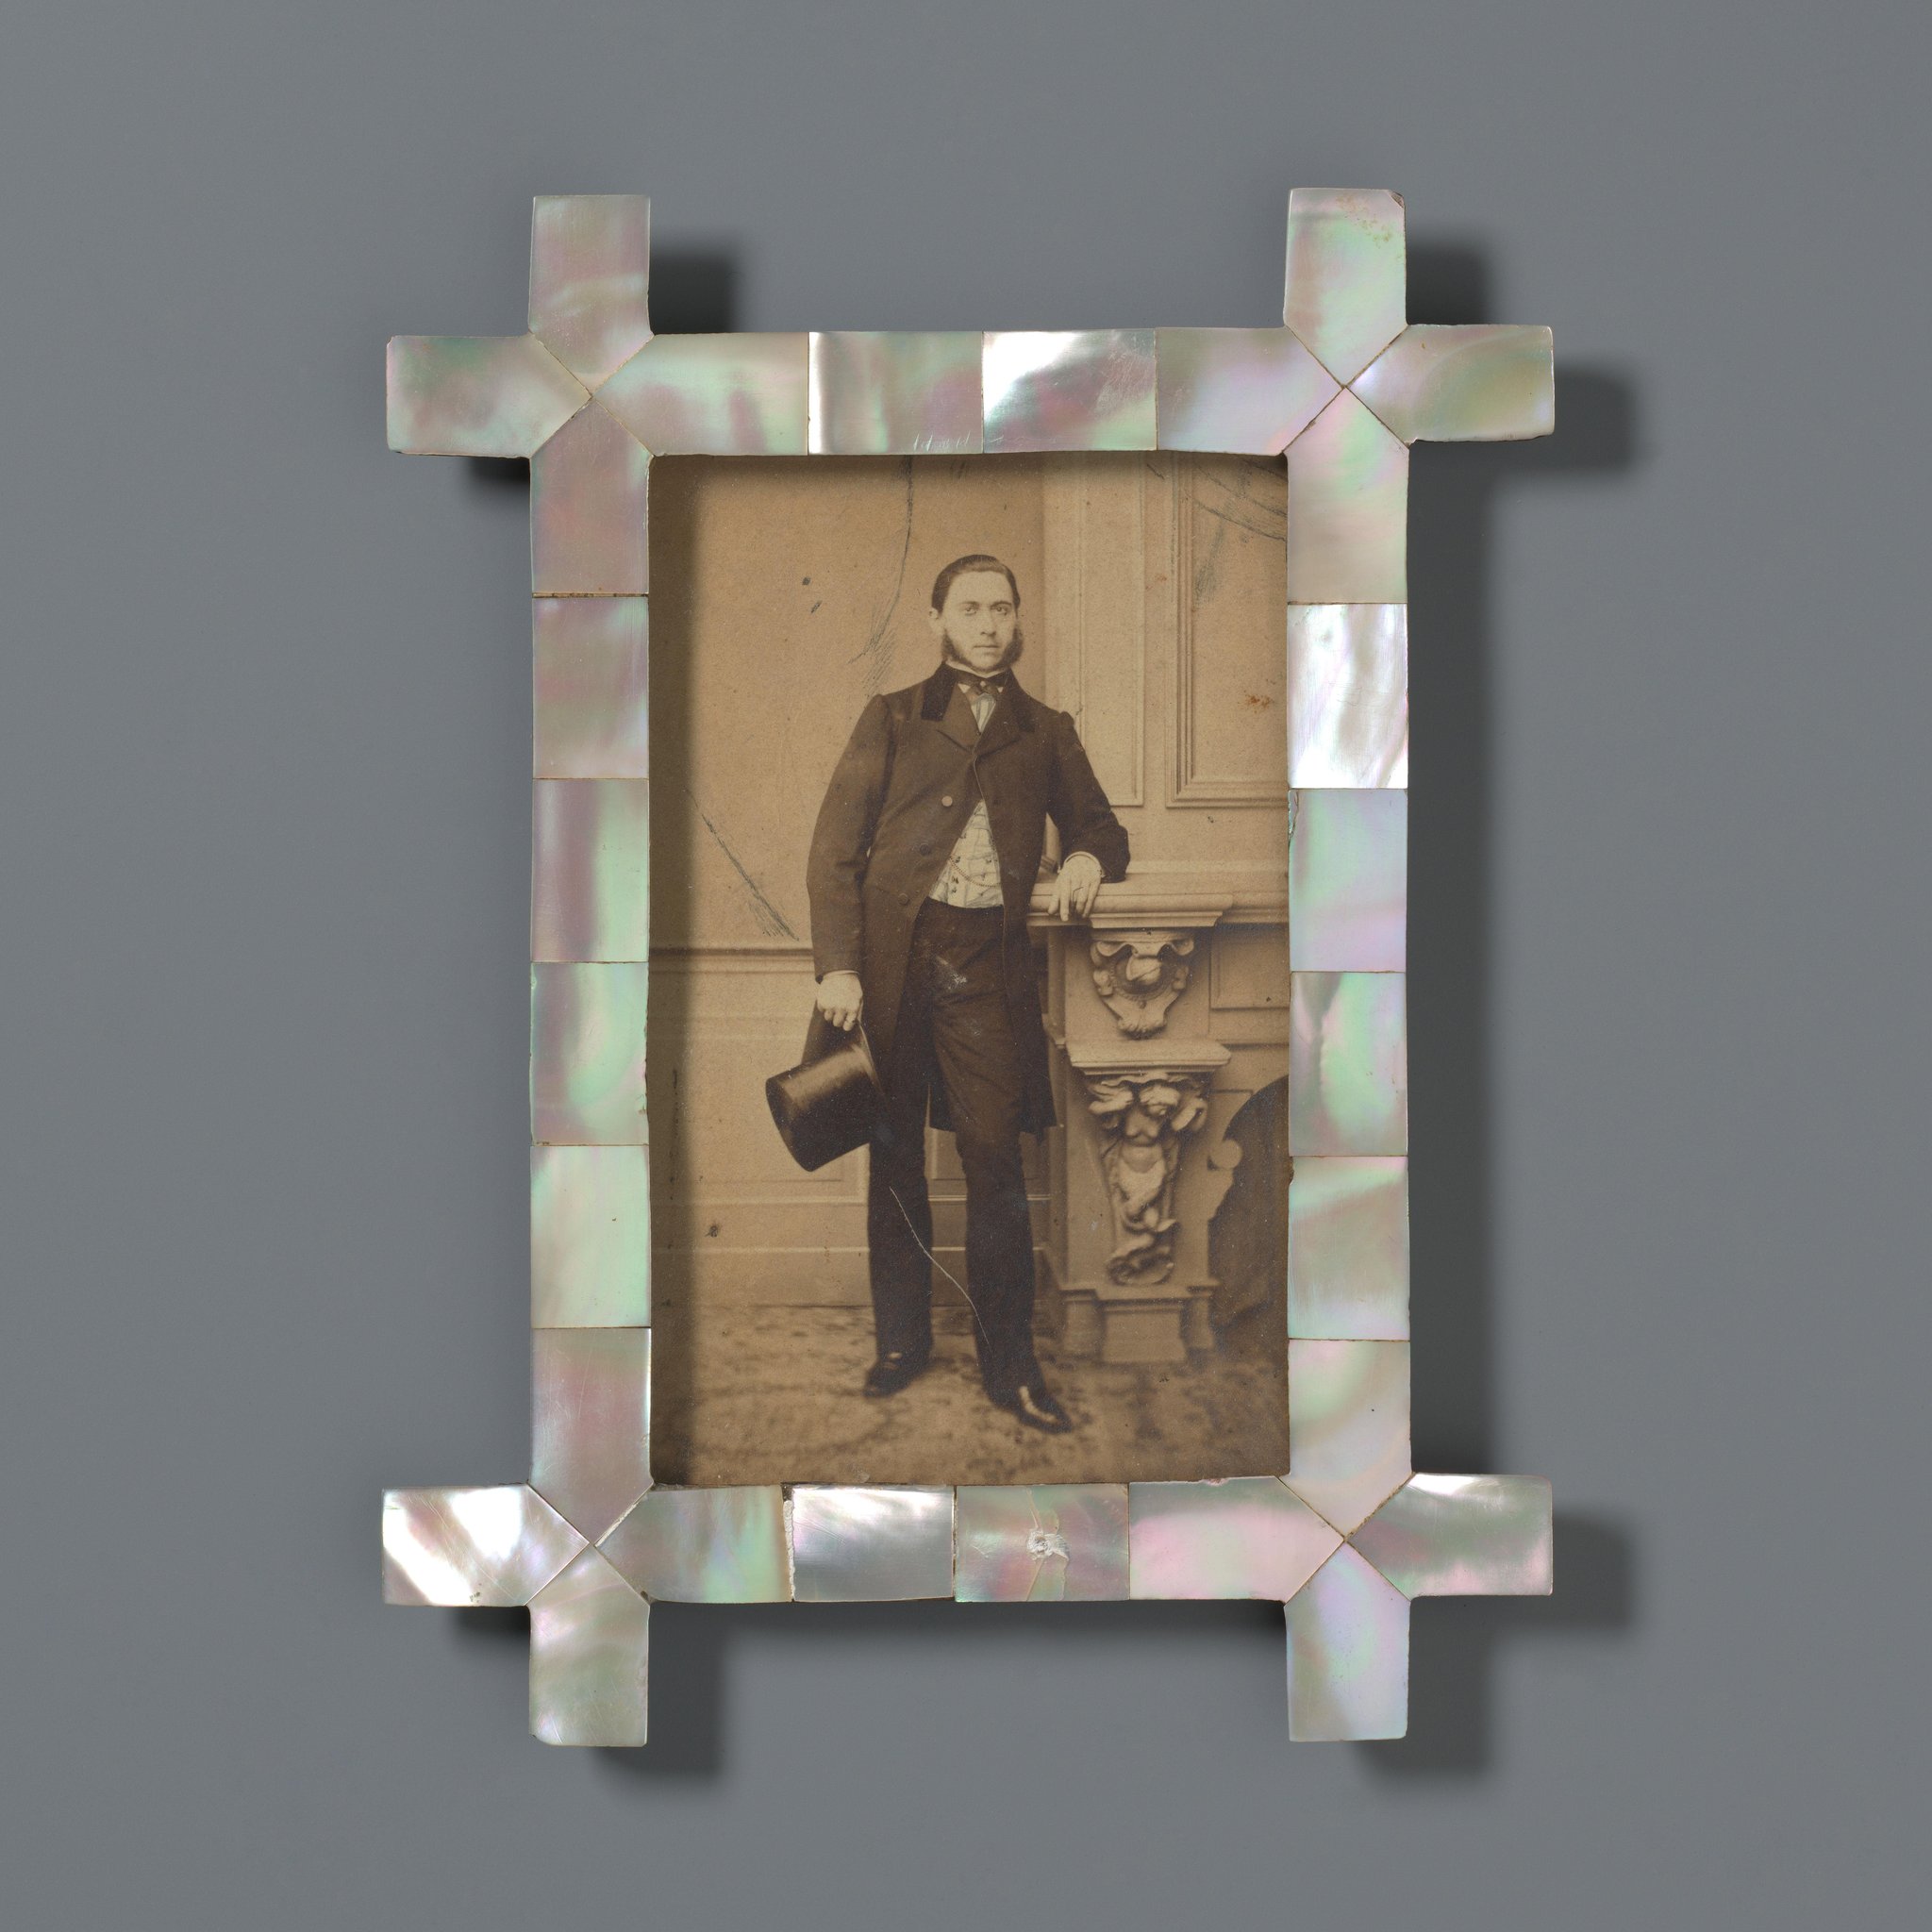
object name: carte de visite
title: Portret van een onbekende man bij een schouw, hoge hoed in de hand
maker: Anonymous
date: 1870-1900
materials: cardboard, glass, metal, mother of pearl, paper, wood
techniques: albumen print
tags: adult man, anonymous historical person portrayed, head-gear: top hat